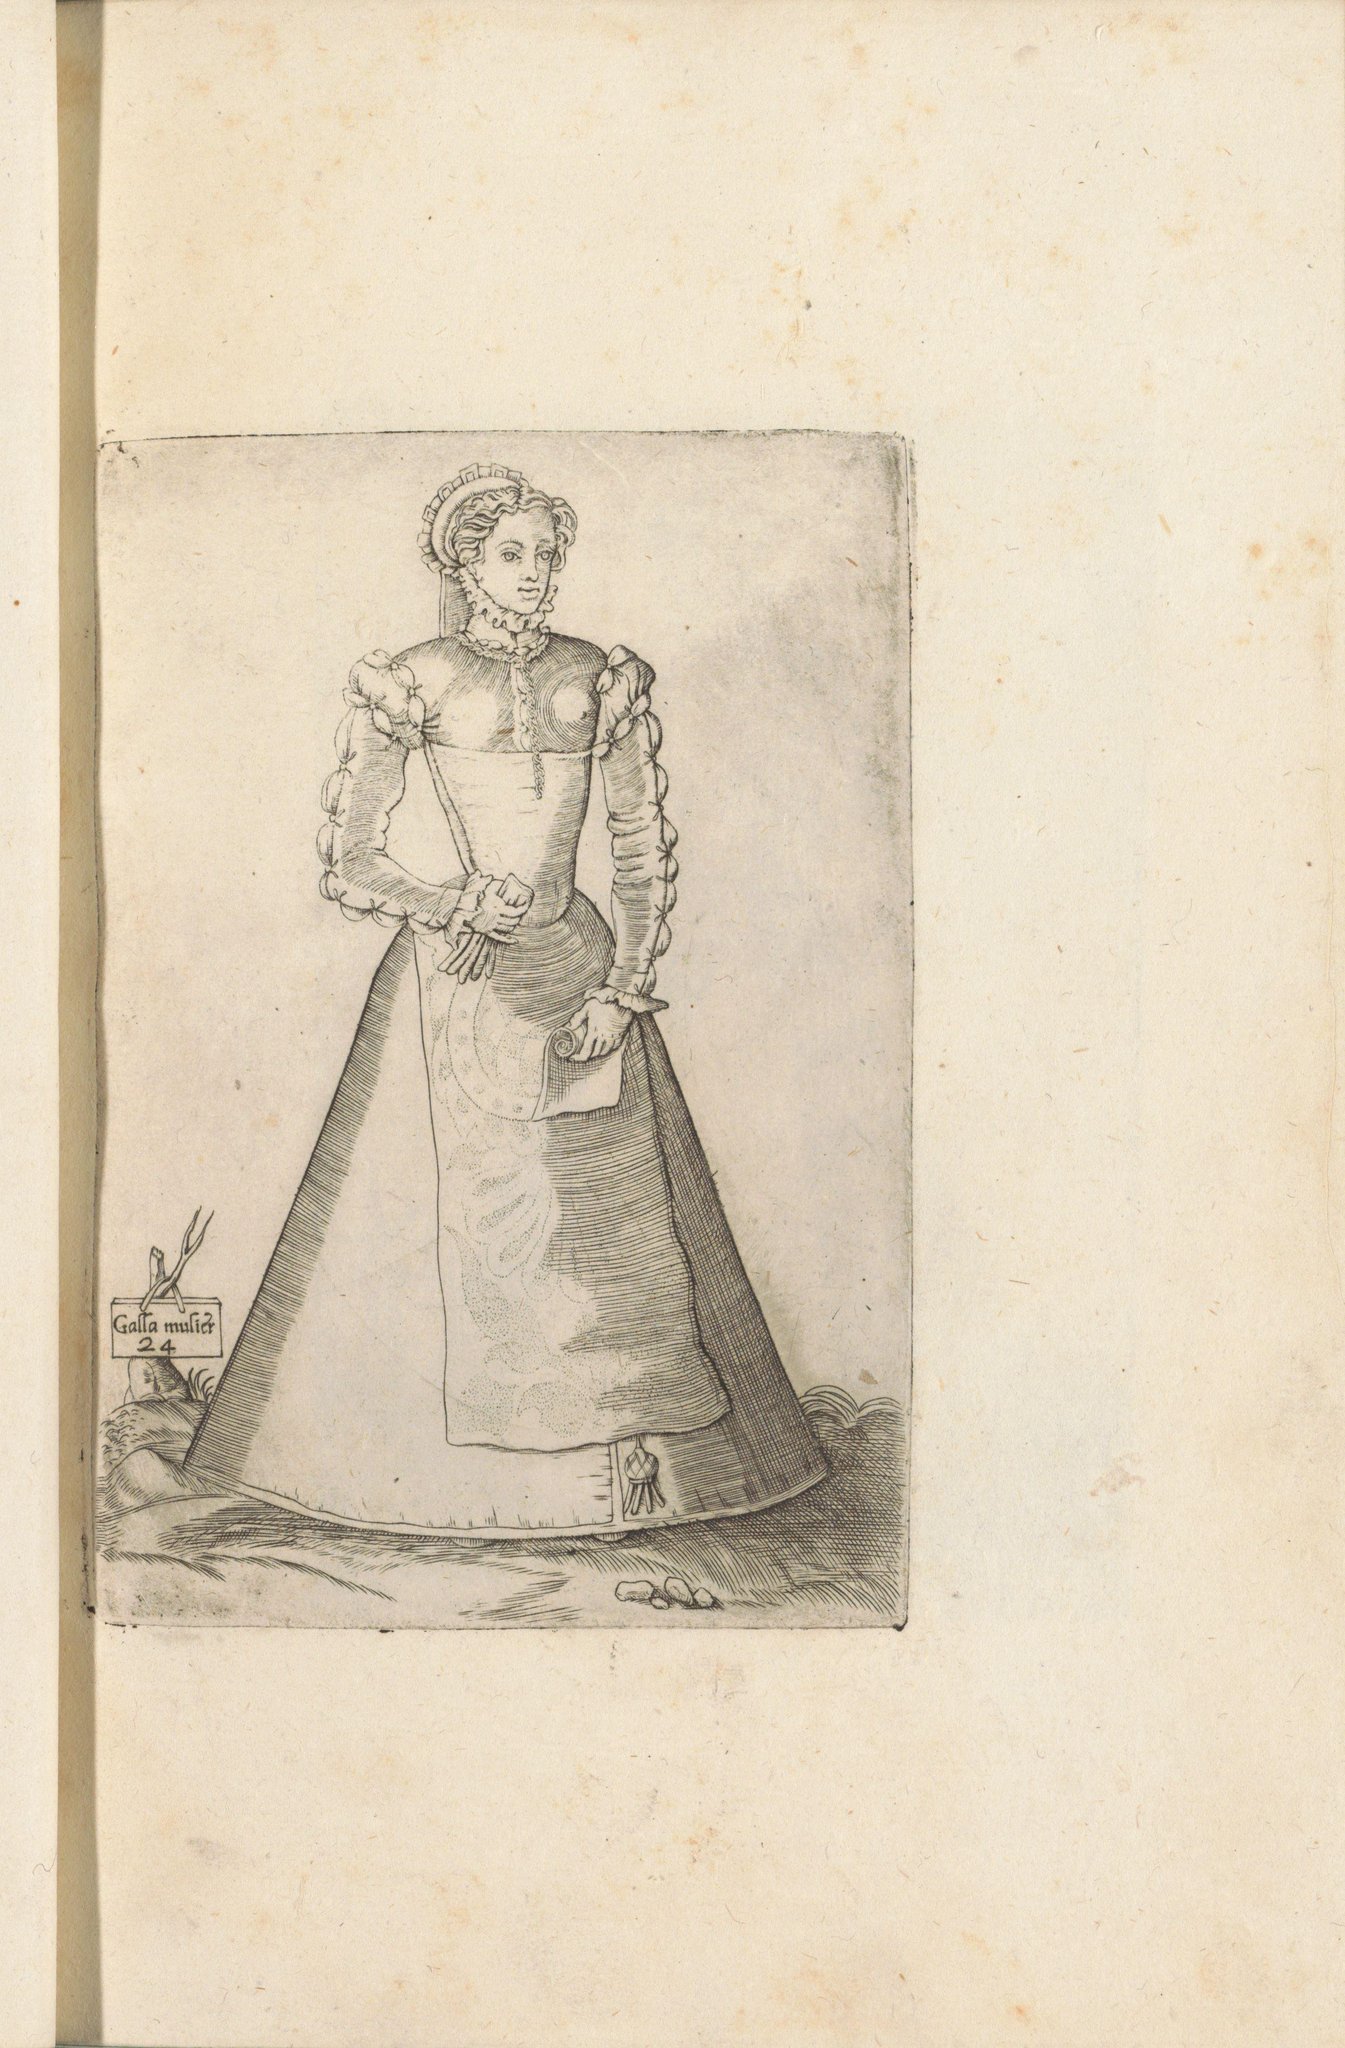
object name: costume print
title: Omnium fere gentium nostrae aetatis habitus, nunquam ante hac aediti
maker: ferando bertelli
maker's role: print maker, publisher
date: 1569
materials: paper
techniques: engraving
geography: venice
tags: europeans (with name) (+ costume), gloves, mittens (short gloves) (+ women's clothes), fashion plates, france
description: Een getrouwde vrouw uit Frankrijk, van voren gezien, handschoen in de rechterhand, doekje in de linkerhand, gekleed volgens de mode van ca. 1550. Onderdeel van het kostuumboek getiteld 'Omnium fere gentium nostrae aetatis habitus, nunquam ante hac aediti', Venetië 1569. Heruitgave uit 1569 van de eerste editie uit 1563.